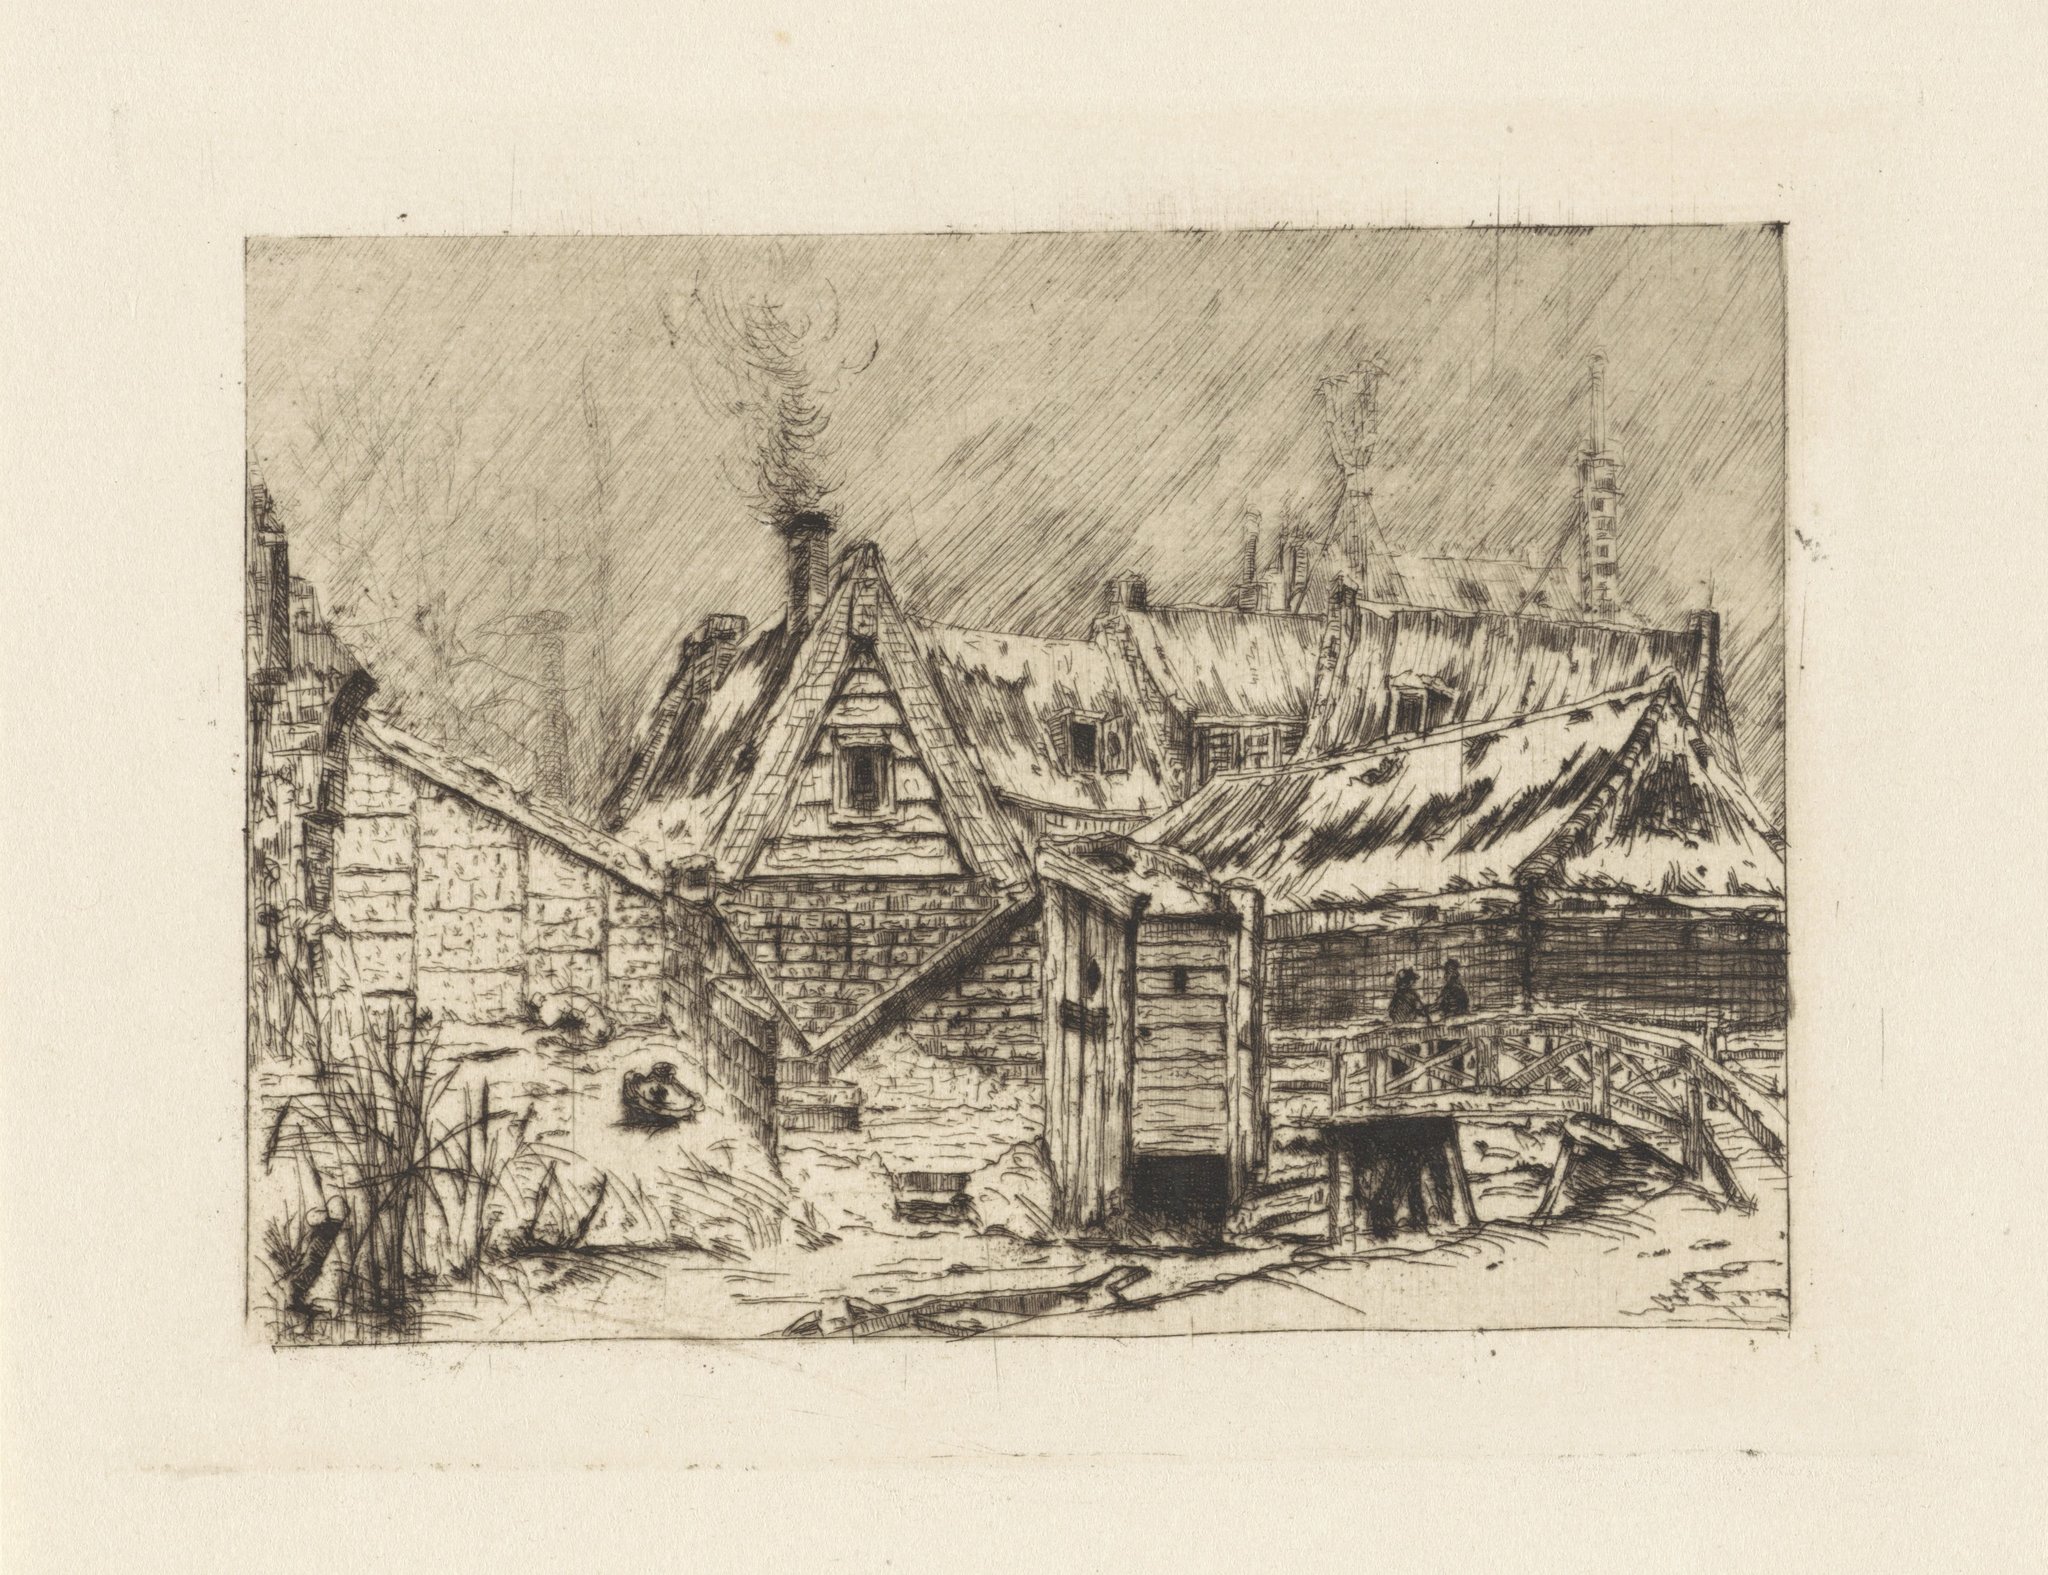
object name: print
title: Woningen met rokende schoorstenen te Amsterdam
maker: frans schikkinger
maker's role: print maker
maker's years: 1838-1902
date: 1848-1902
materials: paper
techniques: drypoint, etching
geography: amsterdam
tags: urban housing, amsterdam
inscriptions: collector's mark: Lugt 2228, inscription: ‘Trapjesdekant’